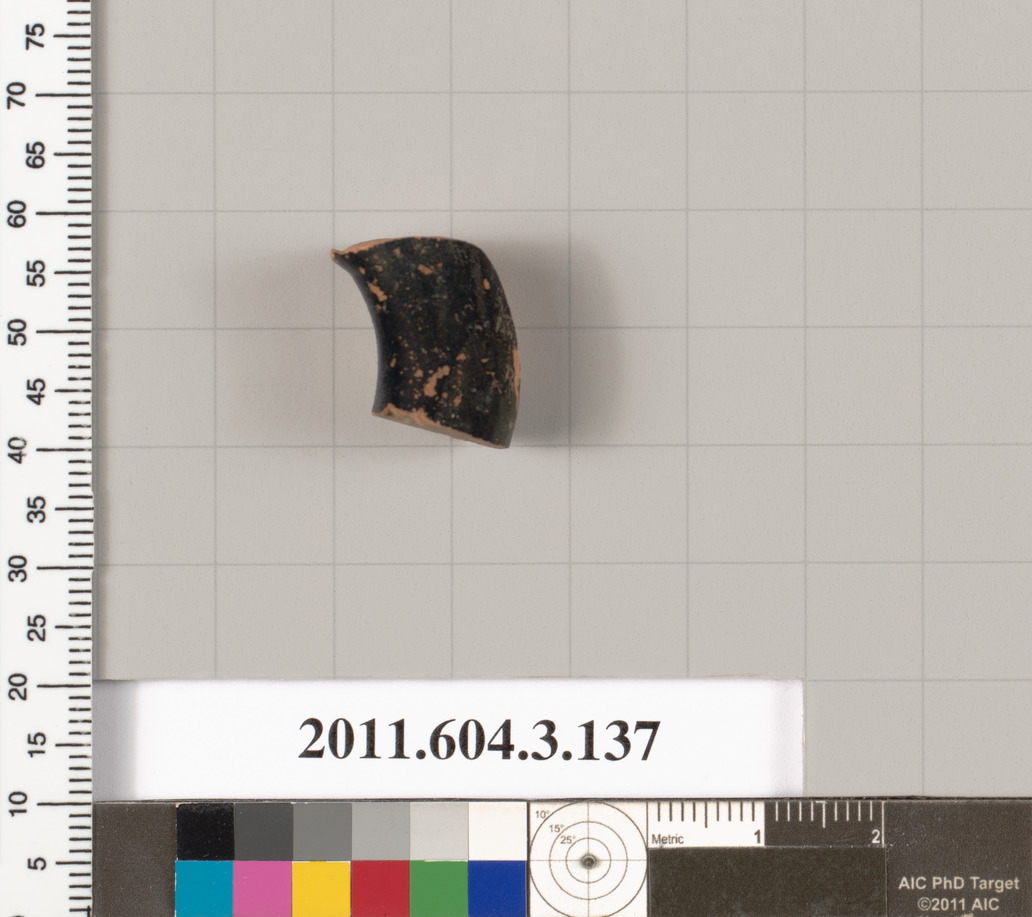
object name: undetermined shape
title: Terracotta fragment from an undetermined shape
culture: greek, attic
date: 600-401 BCE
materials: terracotta